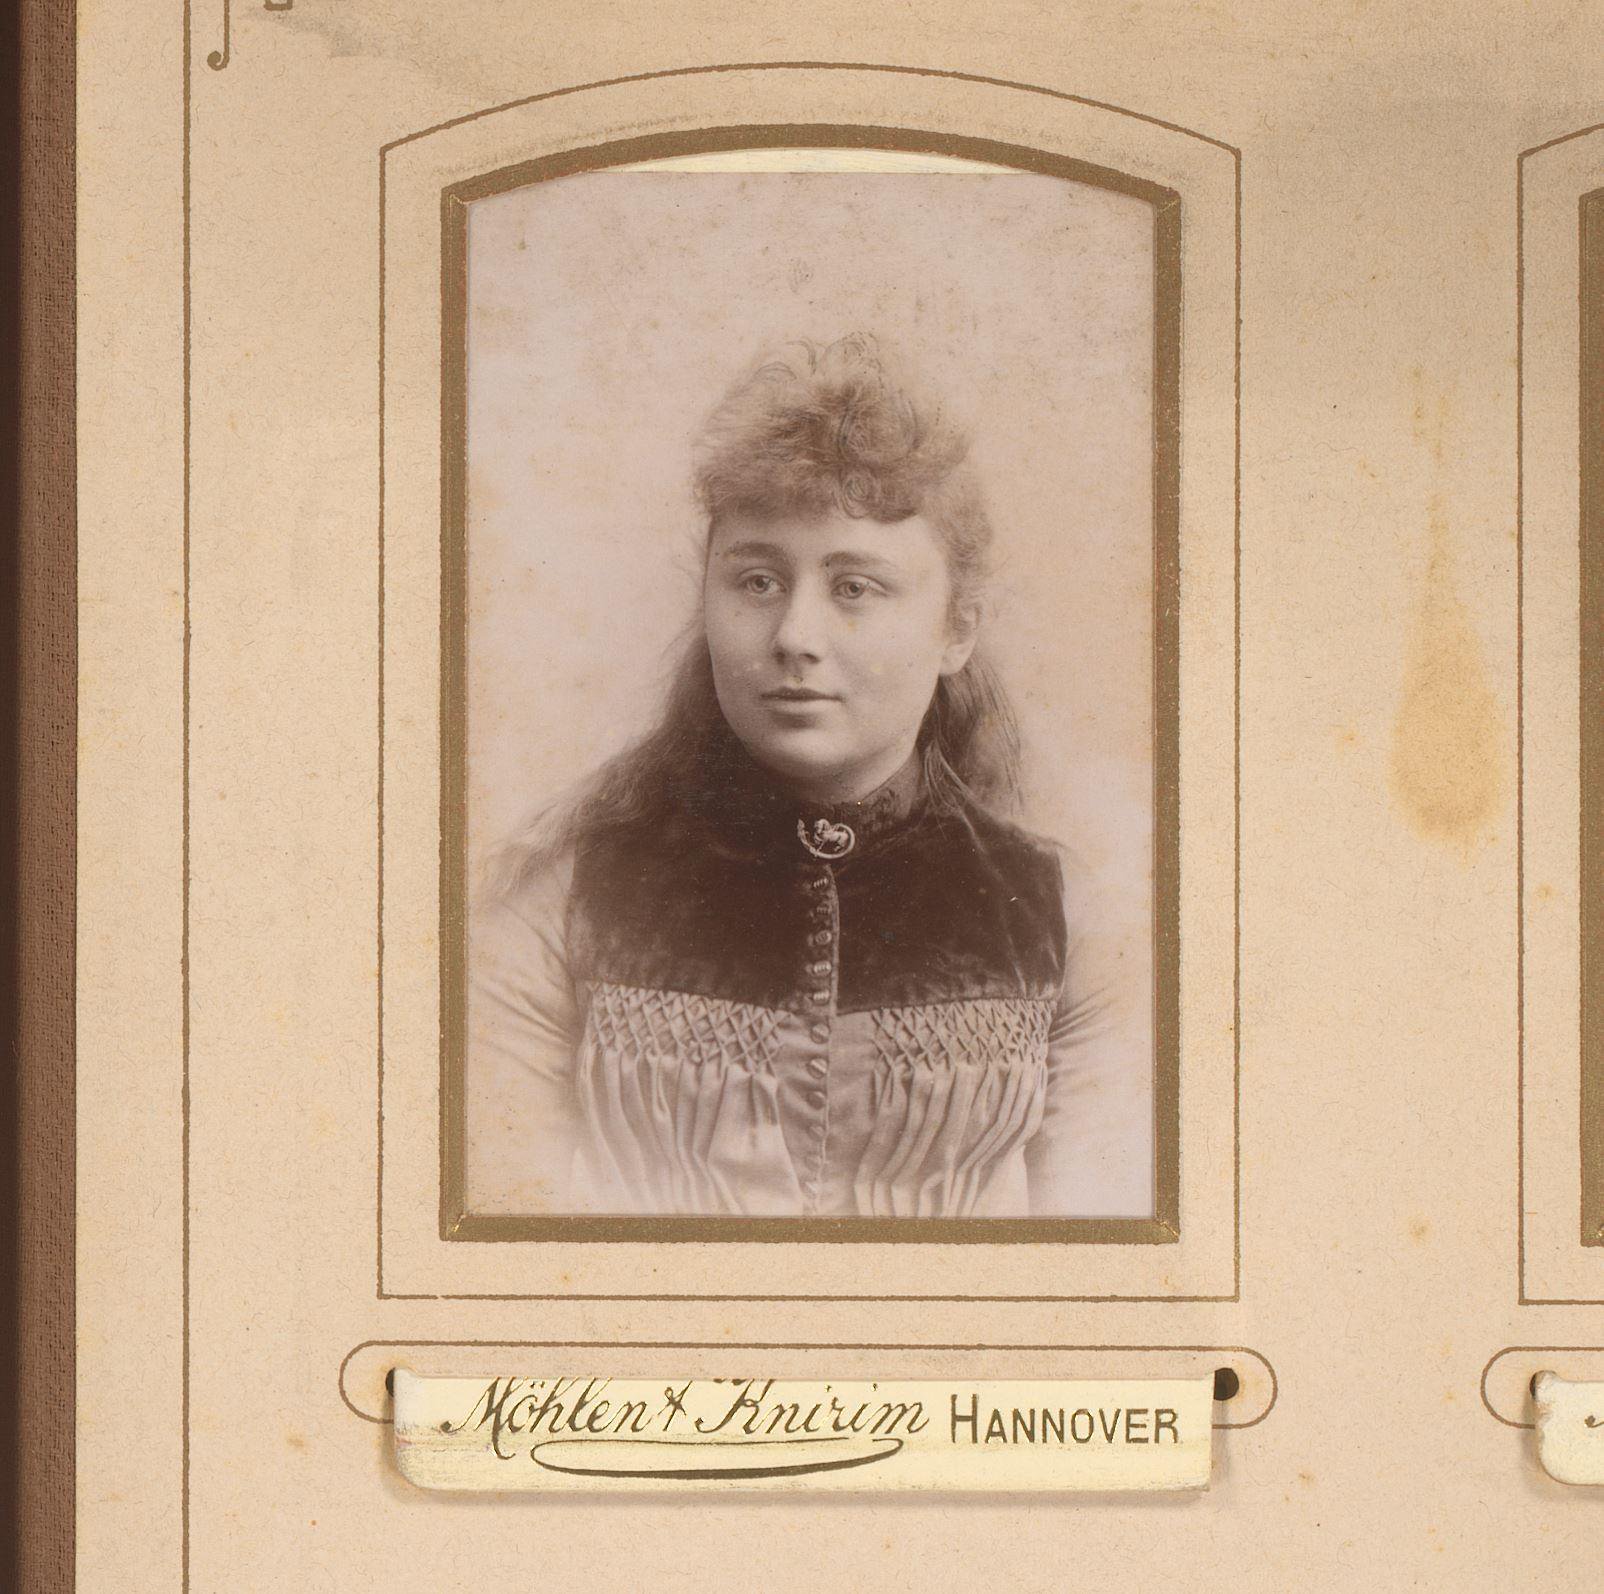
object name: photograph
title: Portret van een meisje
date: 1880-1900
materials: cardboard, photographic support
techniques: albumen print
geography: hannover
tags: historical persons - bb - woman, girl (child between toddler and youth)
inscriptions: inscription: ‘Möhlen & Knirim/ Hannover’